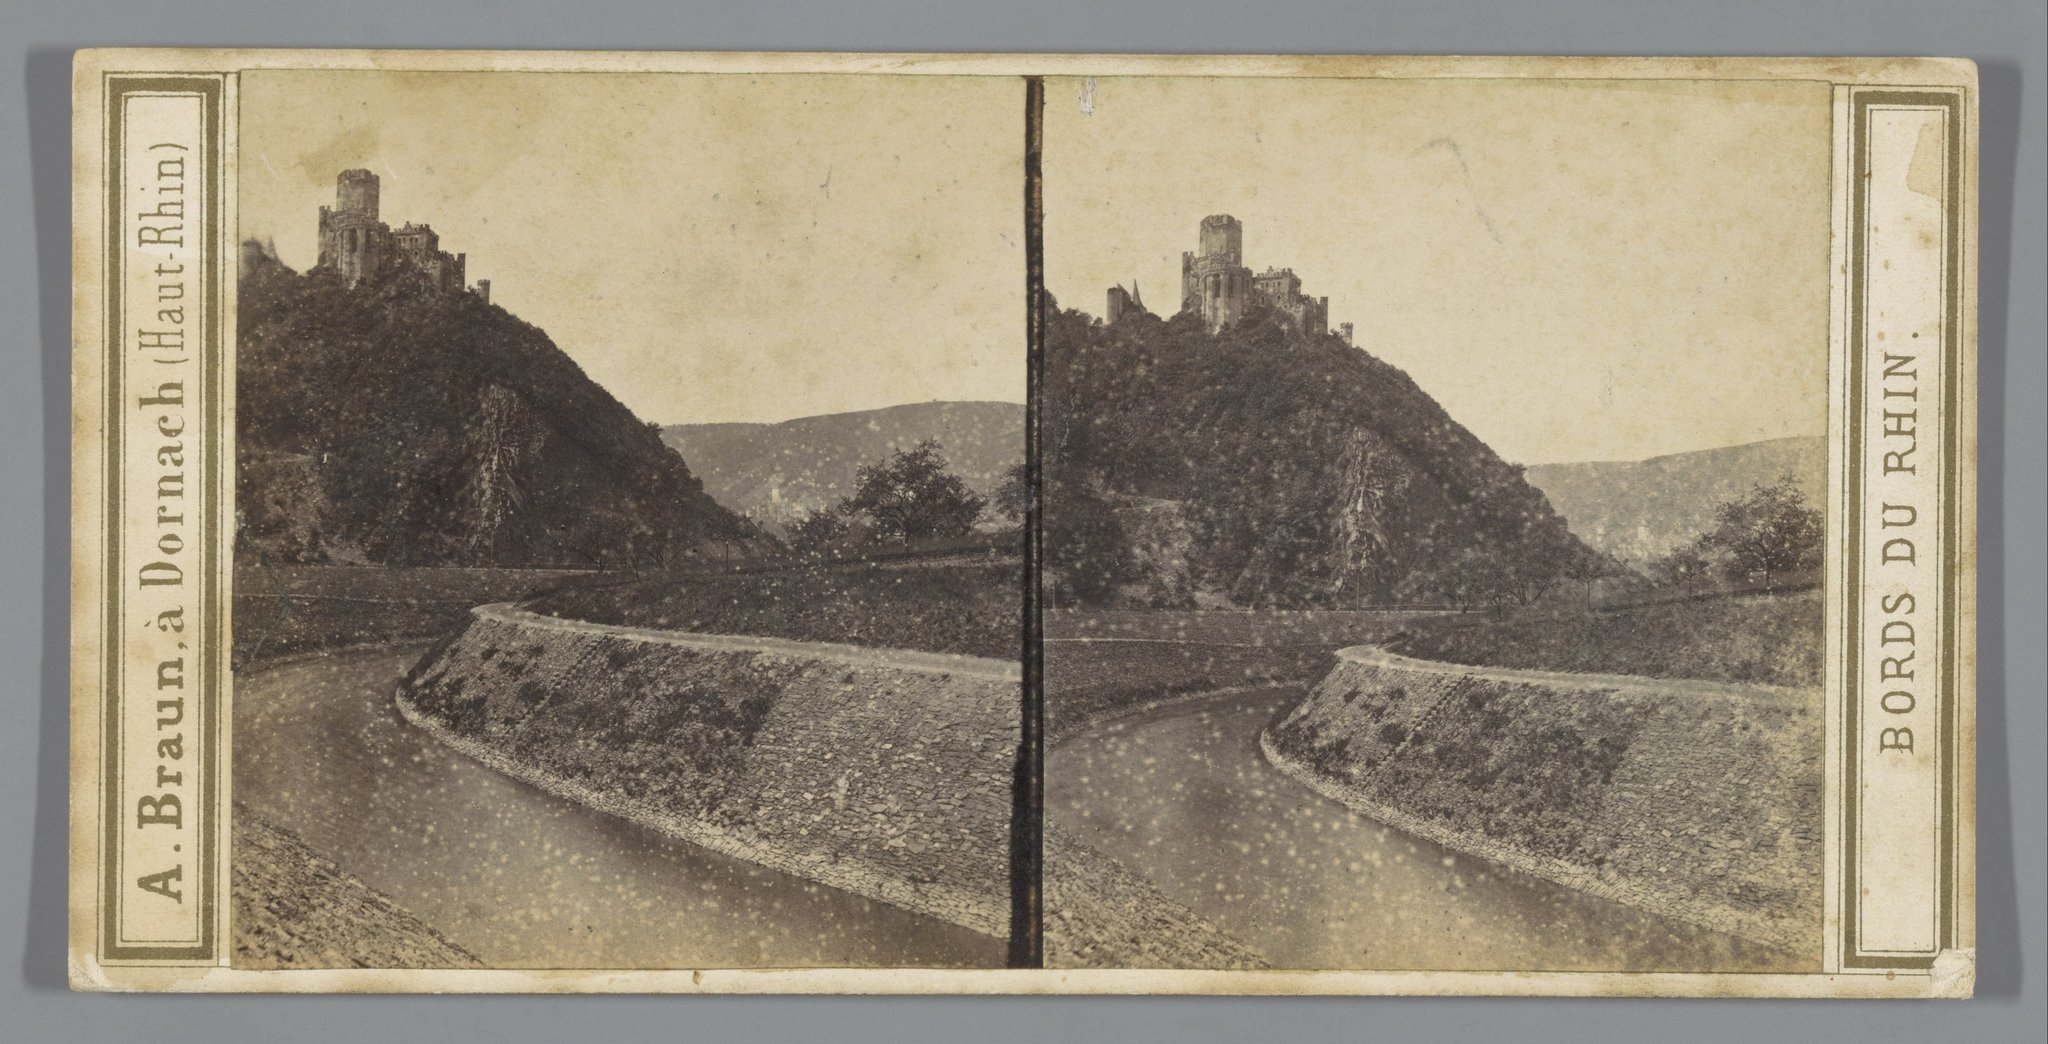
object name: stereograph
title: Bords du Rhin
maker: Anonymous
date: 1860-1866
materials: cardboard, paper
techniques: albumen print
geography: dornach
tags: castle, river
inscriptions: number: ‘2598’